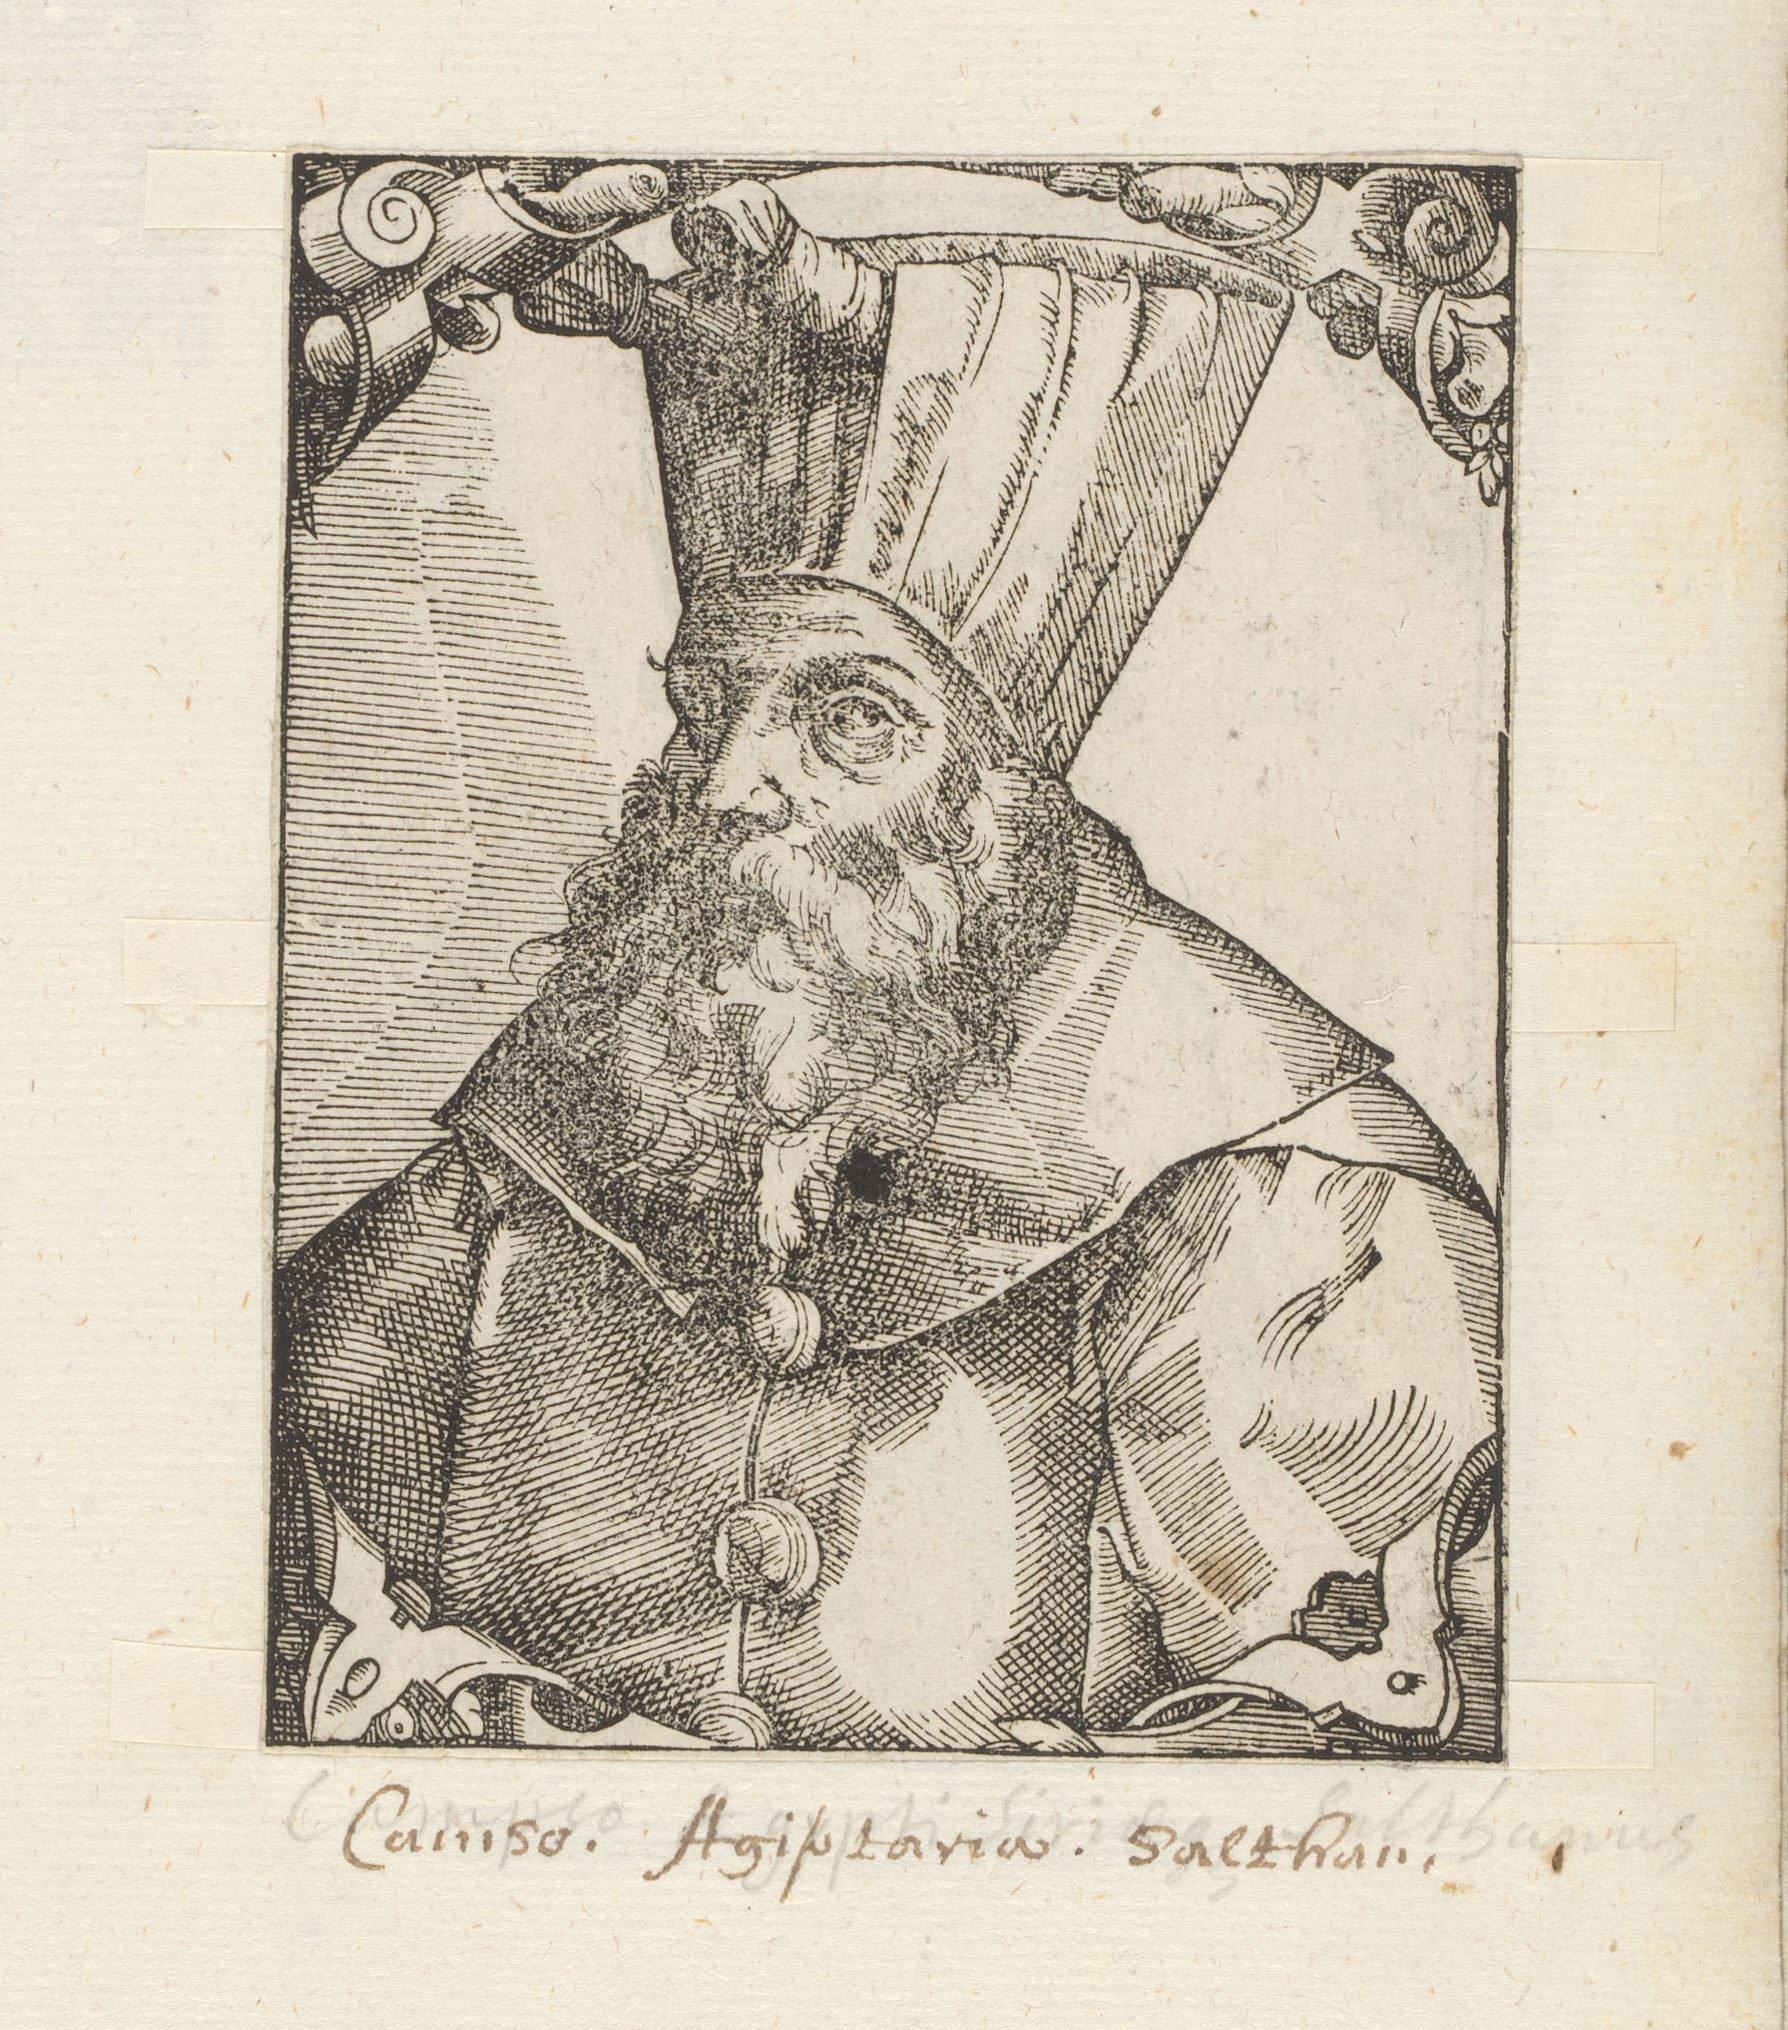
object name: book illustration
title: Portret van sultan Al-Ashraf Qansuh al-Ghawri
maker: Anonymous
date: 1549-1575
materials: paper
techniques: woodcut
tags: historical persons, ruler, sovereign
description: Prent gebruikt in: Giovio, Paolo. Elogia Virorum bellica virtute illustrium (...). Bazel: Peter Perna, 1575.